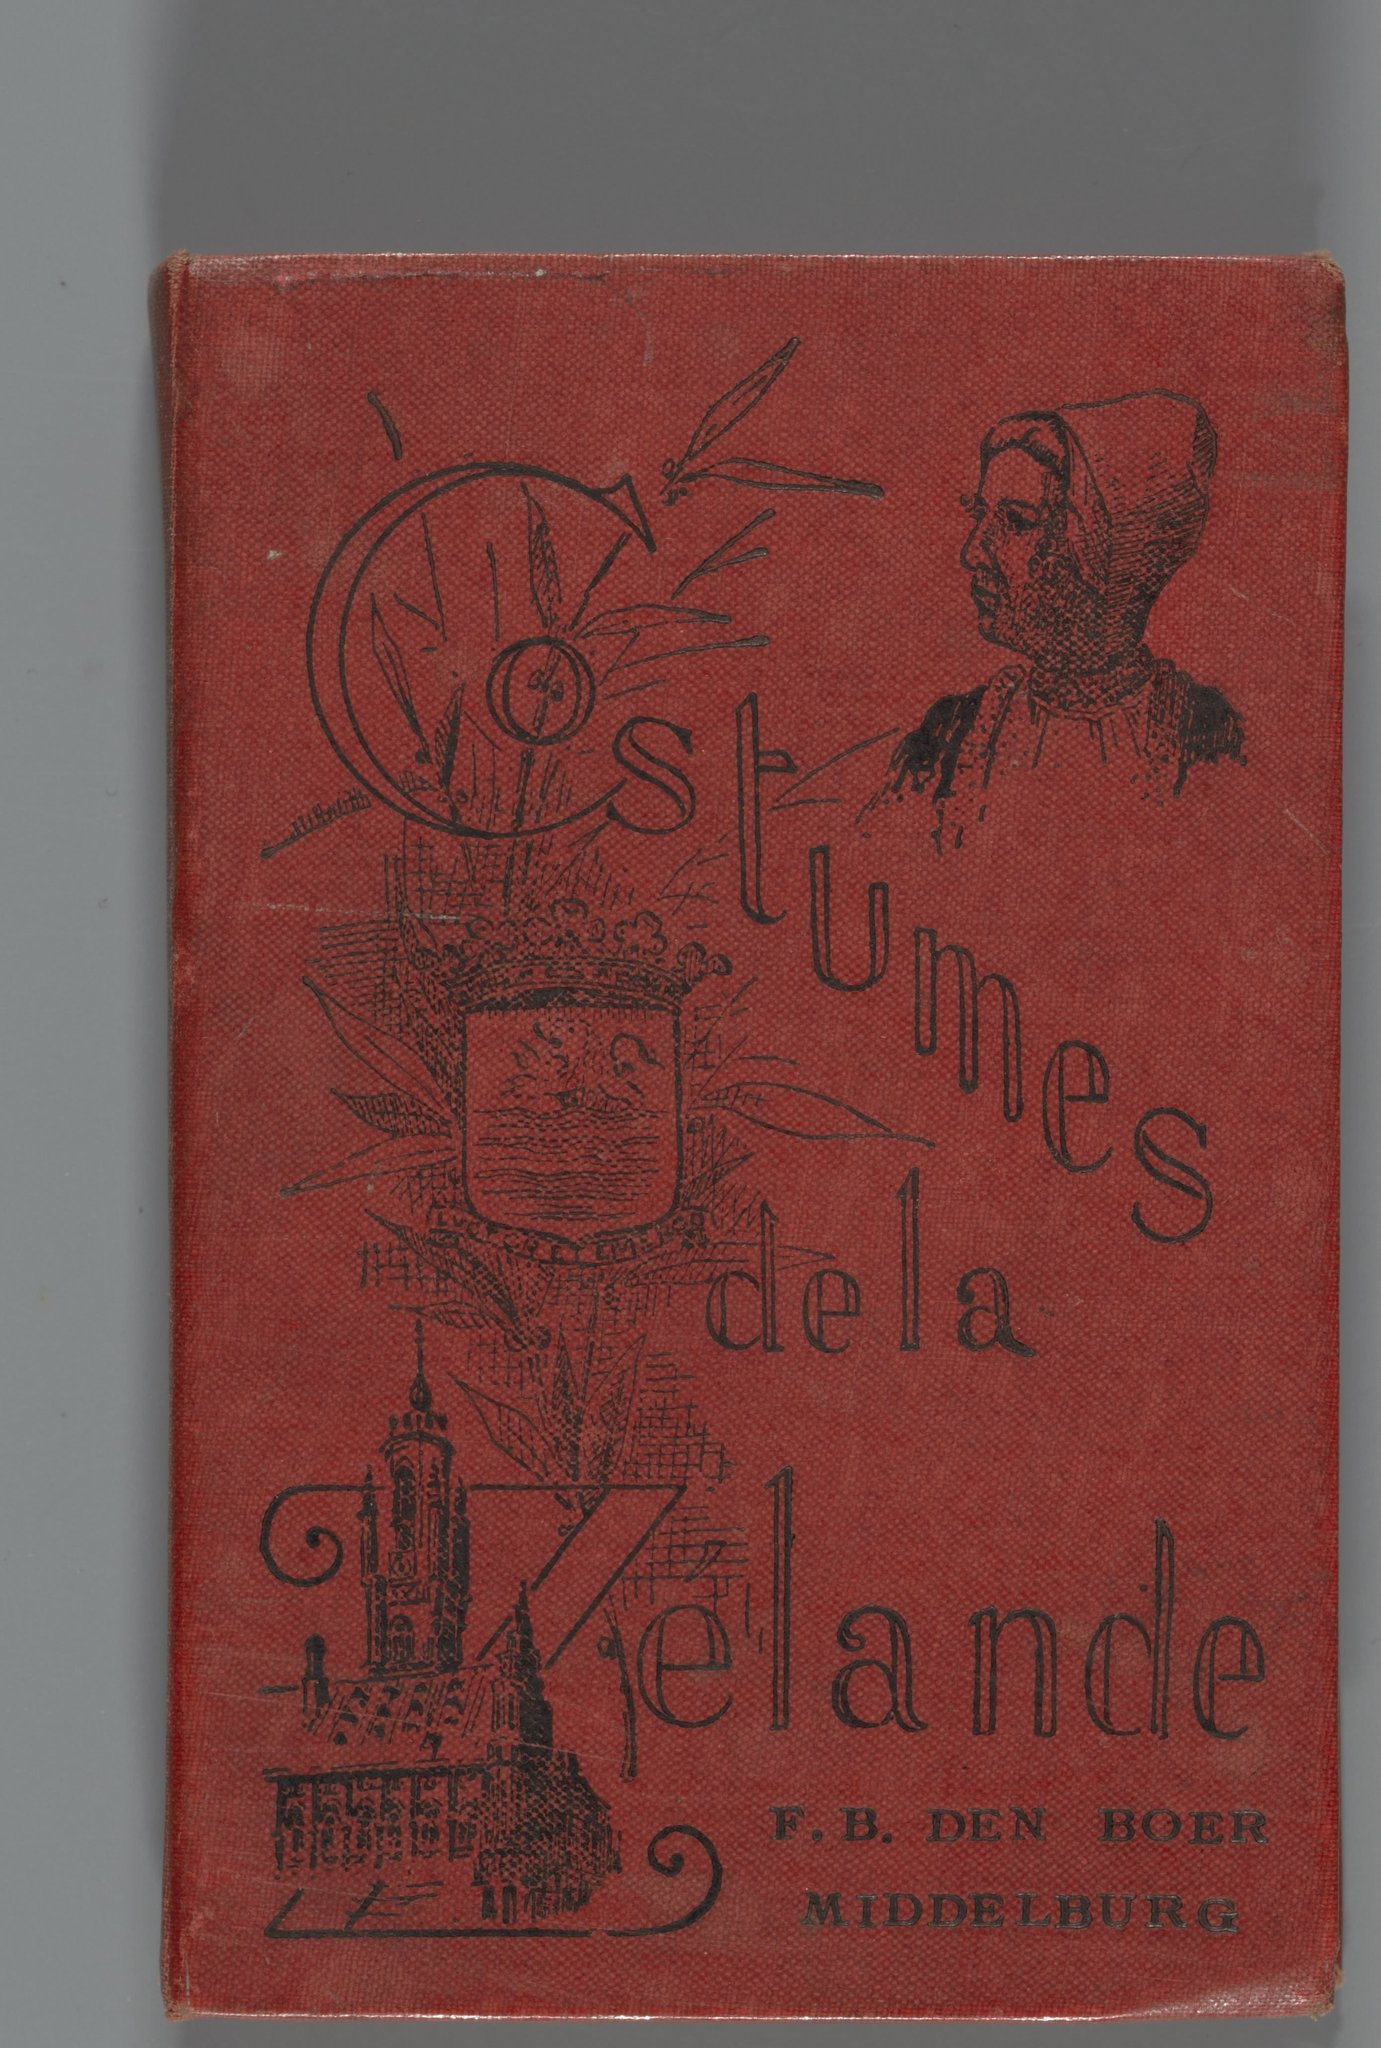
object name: accordion book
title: Costumes de la Zélande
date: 1870-1910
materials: cardboard, linen, paper, photographic support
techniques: albumen print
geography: middelburg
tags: folk costume, regional costume (+ women's clothes), folk costume, regional costume (+ men's clothes), folk costume, regional costume, zeeland, middelburg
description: Leporelloalbum in rode linnen band met op de voorzijde in zwart gedrukt de titel, de naam van de (vermoedelijke) uitgever, alsmede een afbeelding van een kerktoren, het wapen van Zeeland en een Zeeuwse boerin. Het album bevat twaalf aan elkaar vastzittende, uitklapbare kabinetfoto's. Het zijn portretten van mannen, vrouwen en meisjes in de klederdrachten van Walcheren, Goes, Middelburg, Axel en Domburg.